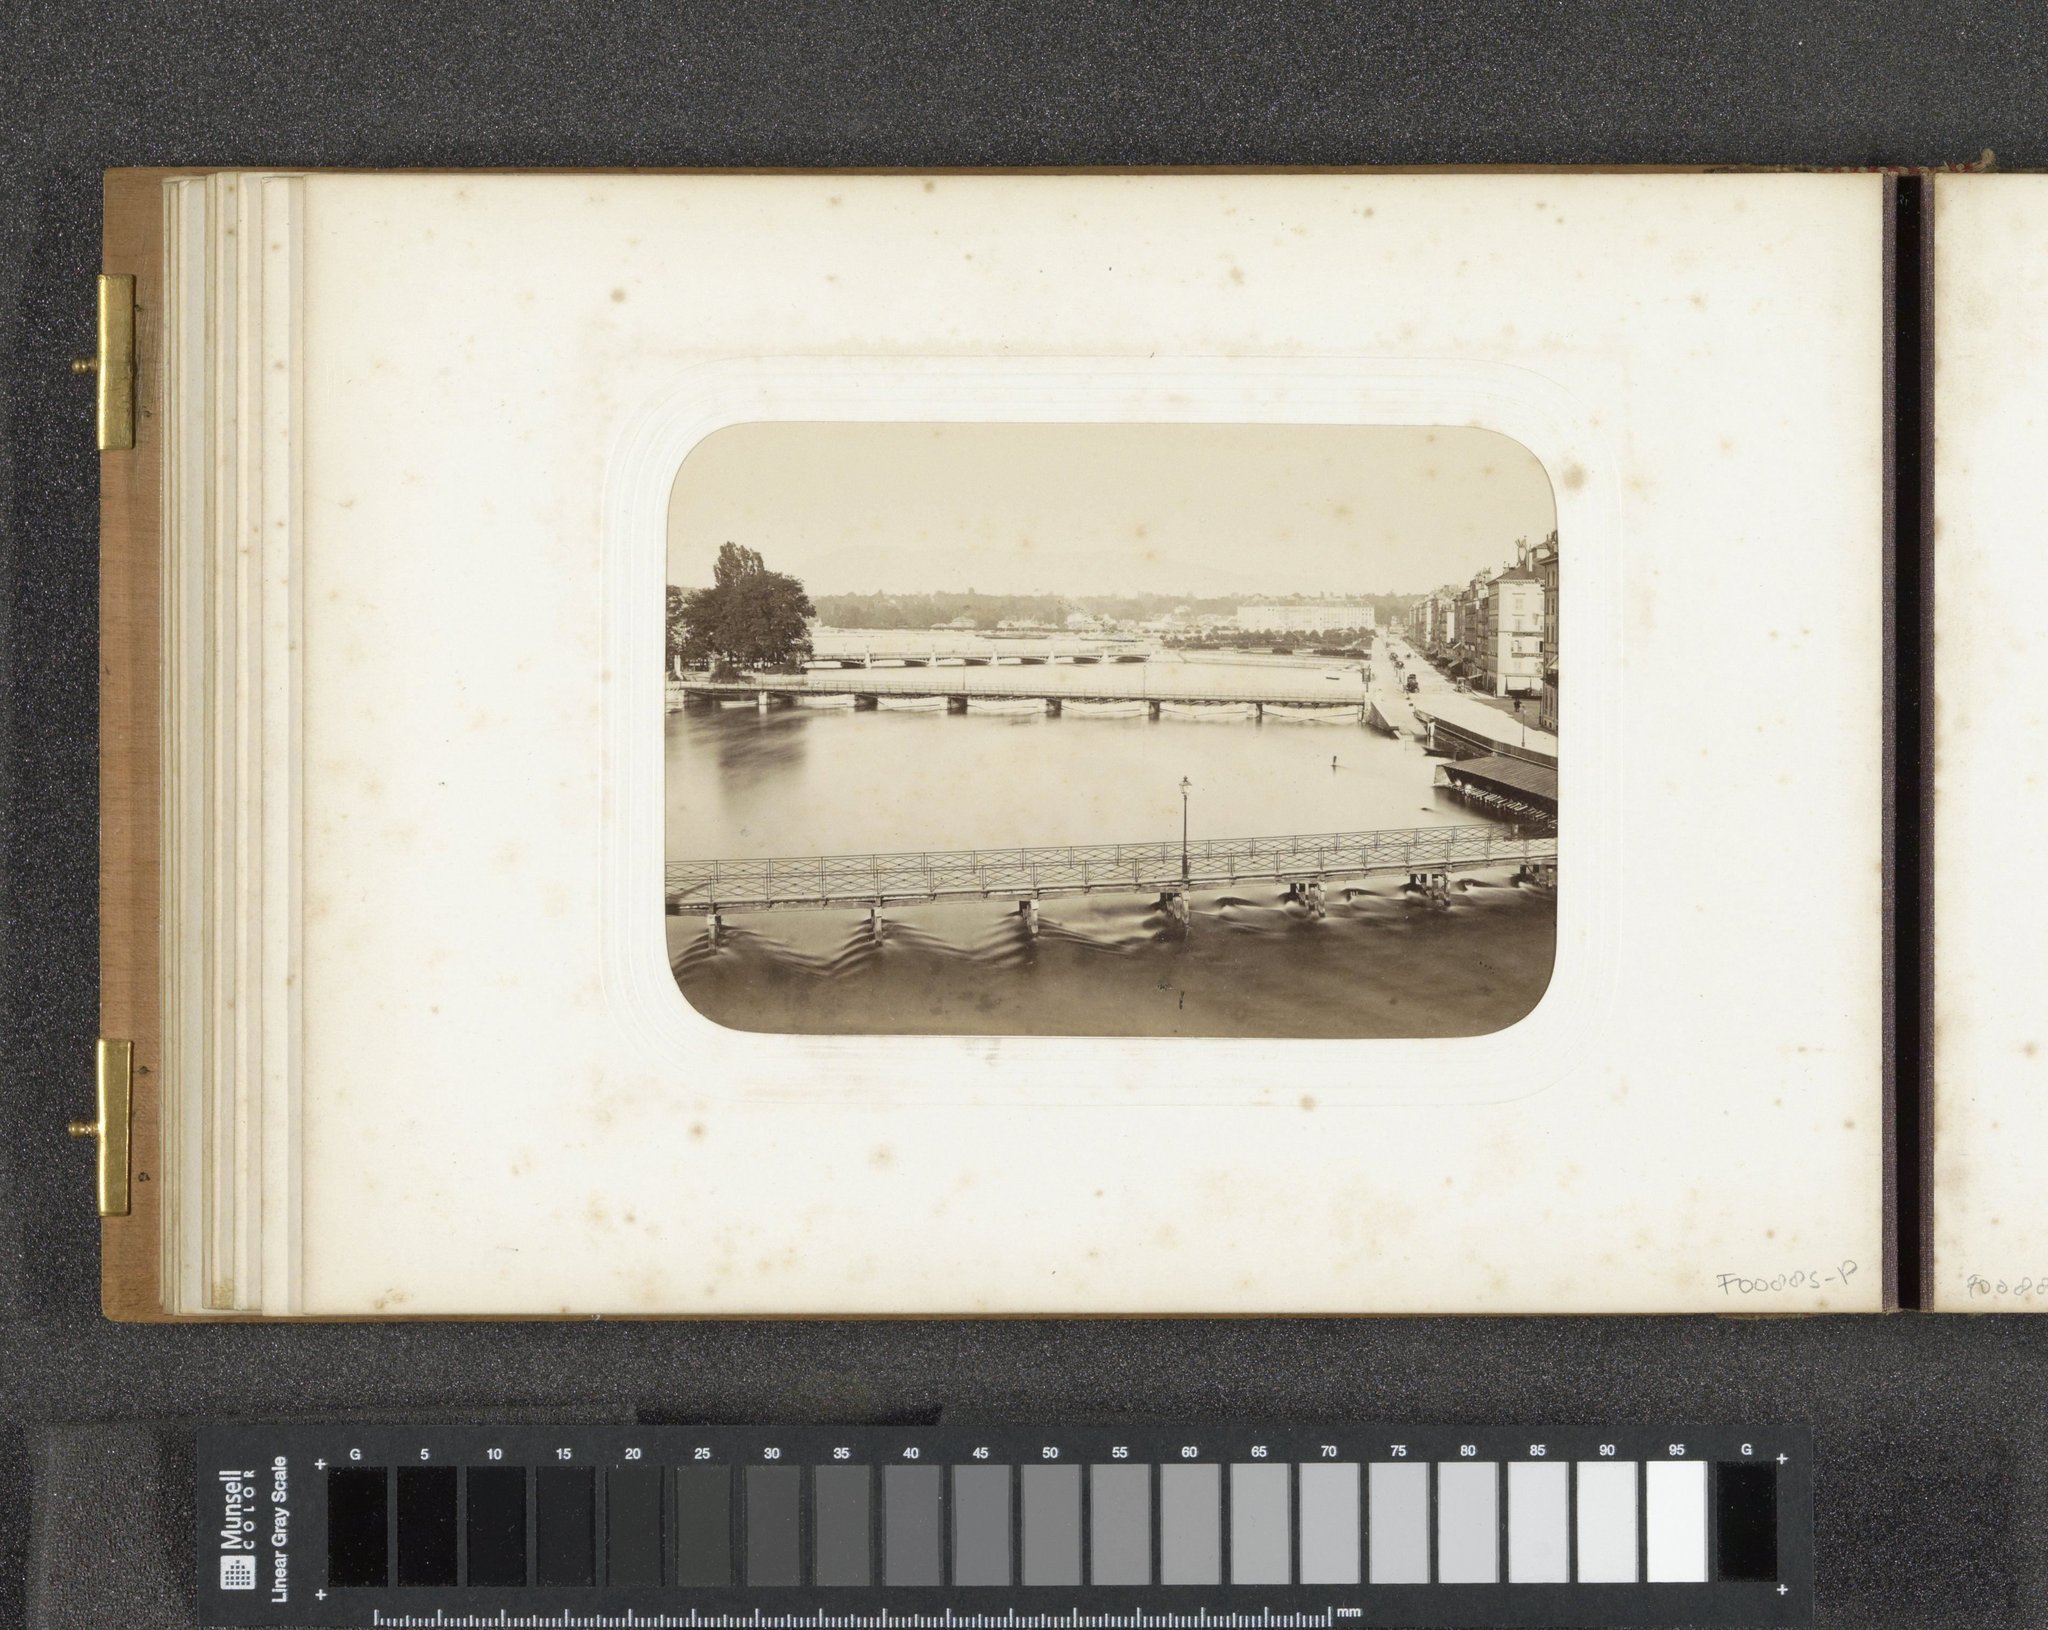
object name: photograph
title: Le grand quai a Geneve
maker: auguste garcin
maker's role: fotograaf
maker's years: 1816-1895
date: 1860-1880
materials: cardboard, paper, photographic support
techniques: albumen print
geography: geneva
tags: quay (+ city(-scape) with figures, staffage), bridge in city across river, canal, etc.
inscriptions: number: ‘20’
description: Onderdeel van Reisalbum met bezienswaardigheden in de Zwitserse Alpen.